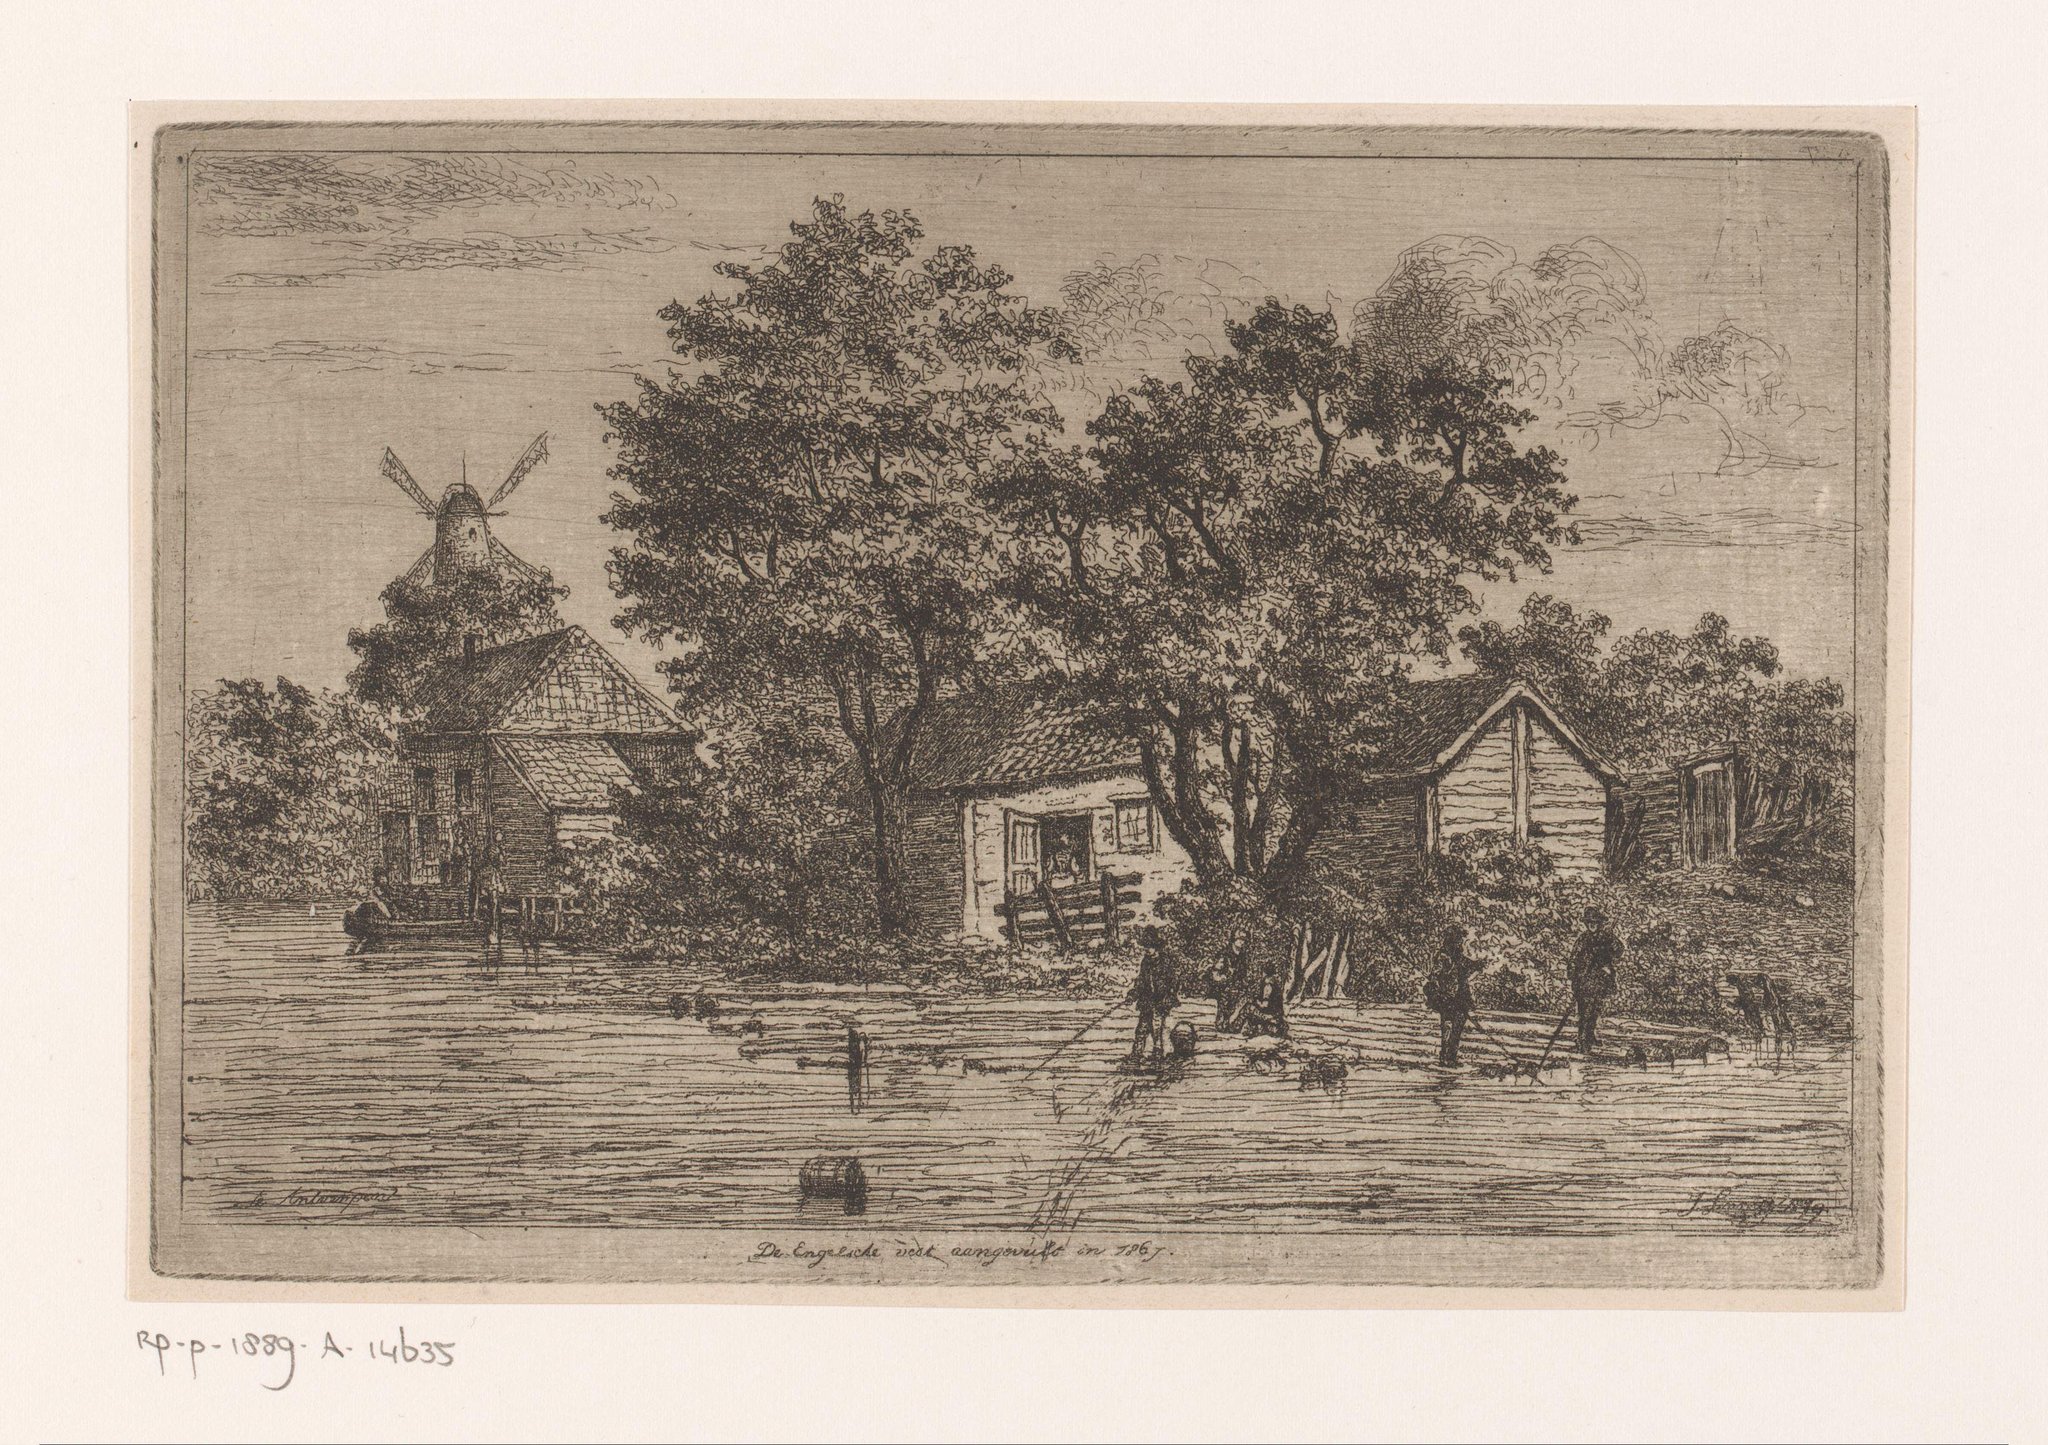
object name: print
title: Gezicht op de Engelse vest in Antwerpen waarop boomstammen verzameld worden, op de achtergrond bebouwing en een molen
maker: jean théodore joseph linnig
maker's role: draughtsman, print maker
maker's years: 1815-1891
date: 1879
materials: paper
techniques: etching, intaglio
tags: timber floating down the river, windmill, antwerp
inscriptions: collector's mark: Lugt 2228